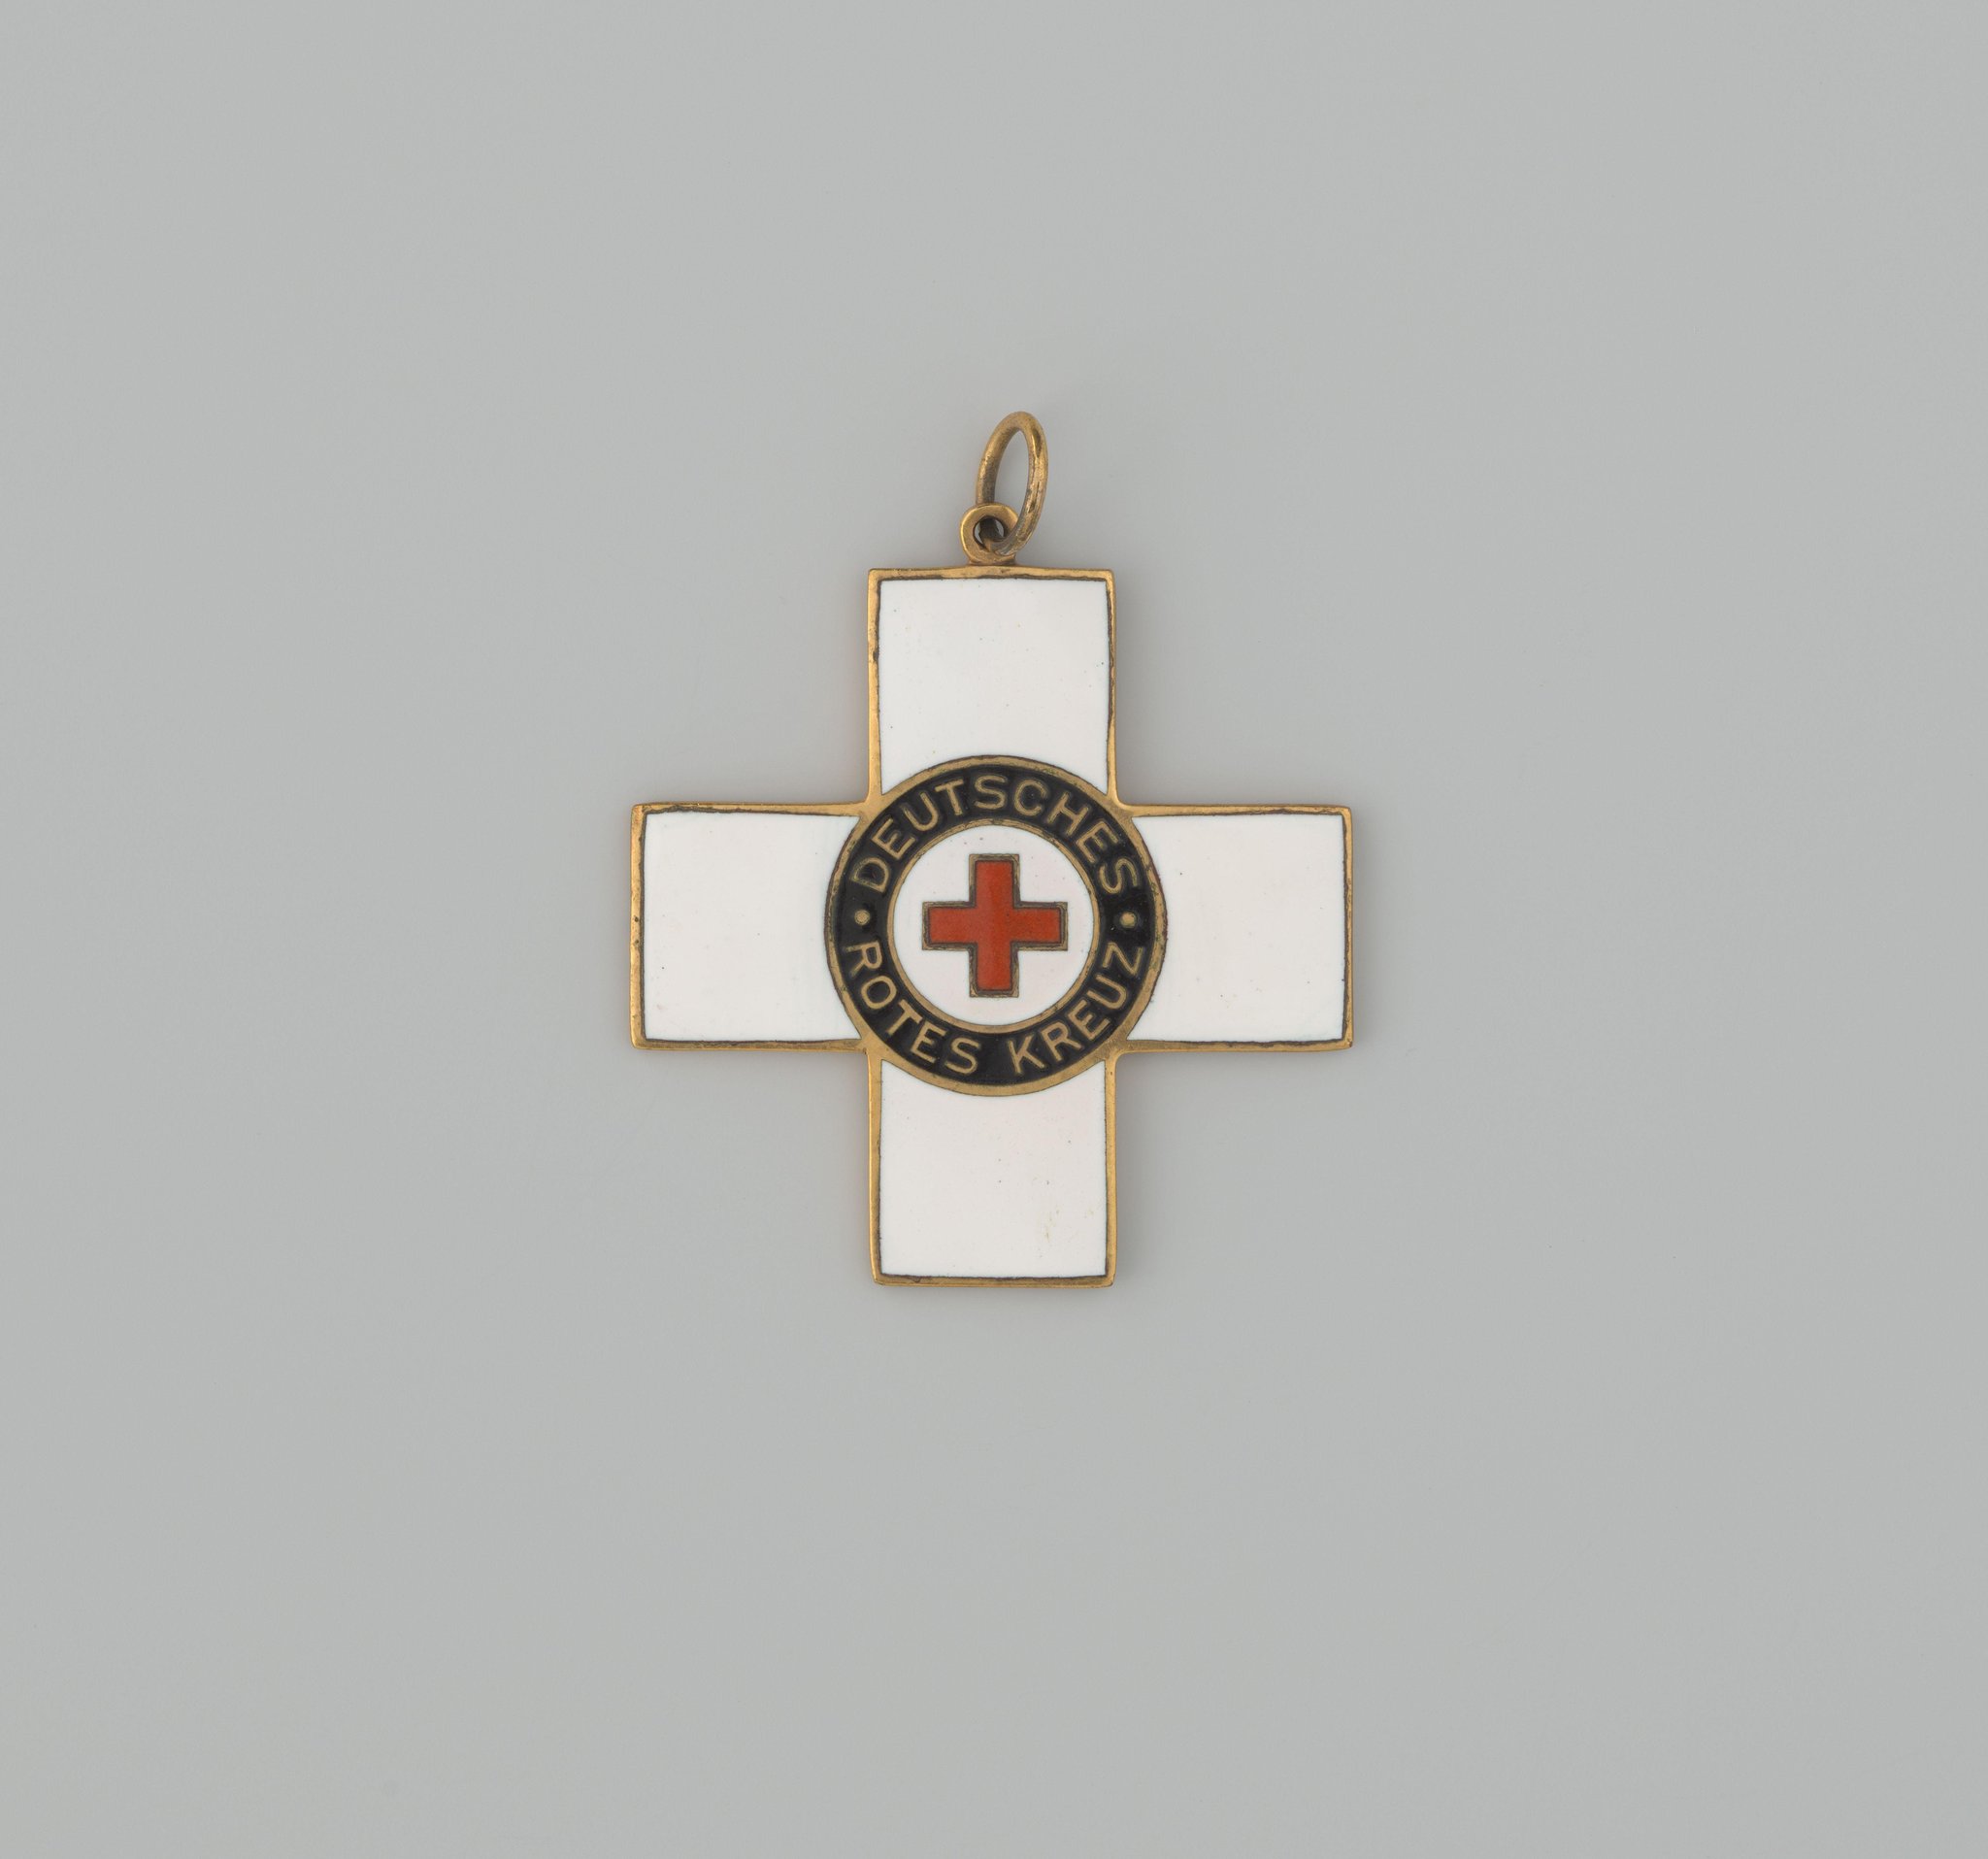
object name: onderscheidingsteken, onderscheiding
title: Ereteken van het Duitse Rode Kruis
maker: Anonymous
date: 1927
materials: silver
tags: else wachenheimer-moos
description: Dit object is onderdeel van de nalatenschap van Isabel Elon-Wachenheimer (1928-2010). Tot haar overlijden behoorde het samen met de andere objecten uit de nalatenschap tot haar privédomein van Isabel Wachenheimer. In die particuliere context zijn deze objecten tezamen en individueel aandenkens - aan de jeugd, ouders en familie van Isabel Wachenheimer vóór en tijdens de Shoah en aan haar leven na de Tweede Wereldoorlog. Isabel Wachenheimer, die van juni 1943 tot mei 1945 gevangen zat in Kamp Westerbork, Theresienstadt, Auschwitz, Lenzing a/d Oberdonau (een buitenkamp van Mauthausen), overleefde de Shoah. Haar ouders – Eugène Wachenheimer en Else Wachenheimer-Moos - werden op 14 oktober 1944 in Auschwitz-Birkenau vermoord.